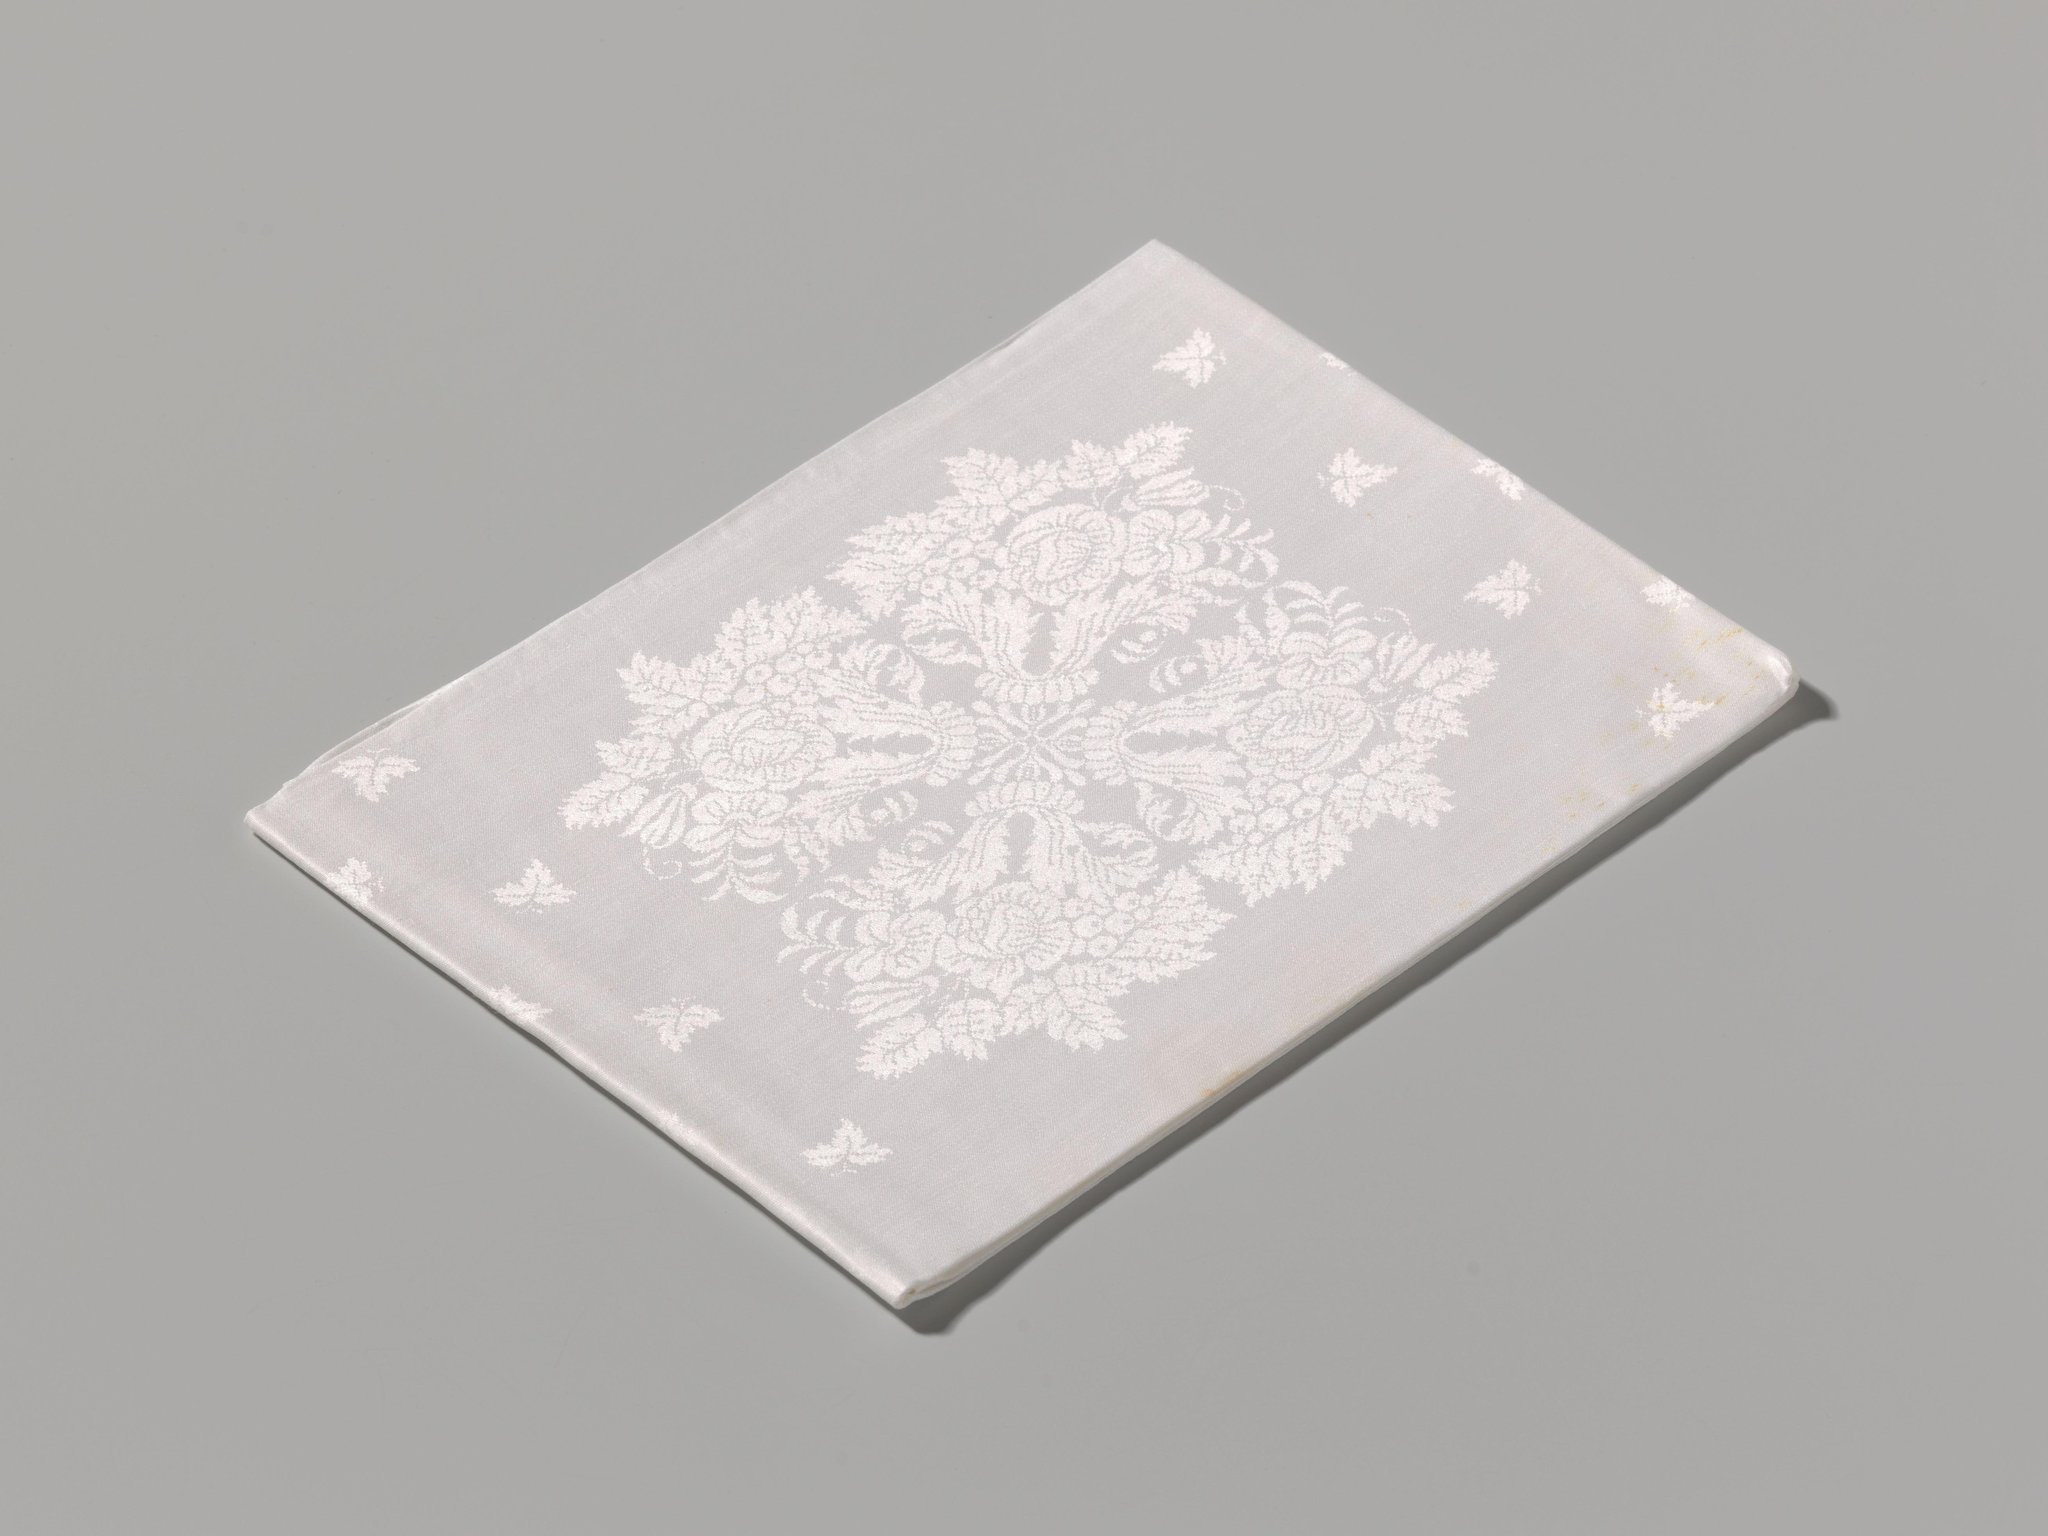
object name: napkin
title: Servet met herme, god en leeuwen te midden van acanthusbladeren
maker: Anonymous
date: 1850-1899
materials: linen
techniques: damask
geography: north brabant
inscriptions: mark: ‘GH 18’, label: ‘R.M.A 'dam’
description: Servet van linnendamast met herme, god, leeuwen te midden van acanthusbladeren. Middenveld: Vierpassen van bloemboeketten met roos en gestrooid bladwerk. In de niet omgrensde vierpassen staan de telkens op twee acanthusvoluten geplaatste boeketten overhoeks. Hoeken: overhoeks geplaatst een herme met Midas-kop (of ezelskop?), met muziekinstrumenten en thyrsusstaven. Links en rechts een toegewende leeuw, in toom gehouden door een gevleugelde jonge God (Apollo?) in draperie gehuld. Randen: zonder scheidingslijn is het veld omgeven door een brede rand van symmetrische acanthusranken. Beurtelings dragen de diep ingesneden, gevederde bladvoluten een vruchten- en bloemenmand, of zij staan in twee toegewende spiraalvormen, die in een ramsmasker eindigen, boven twee bloemtakken en een pijnappel.